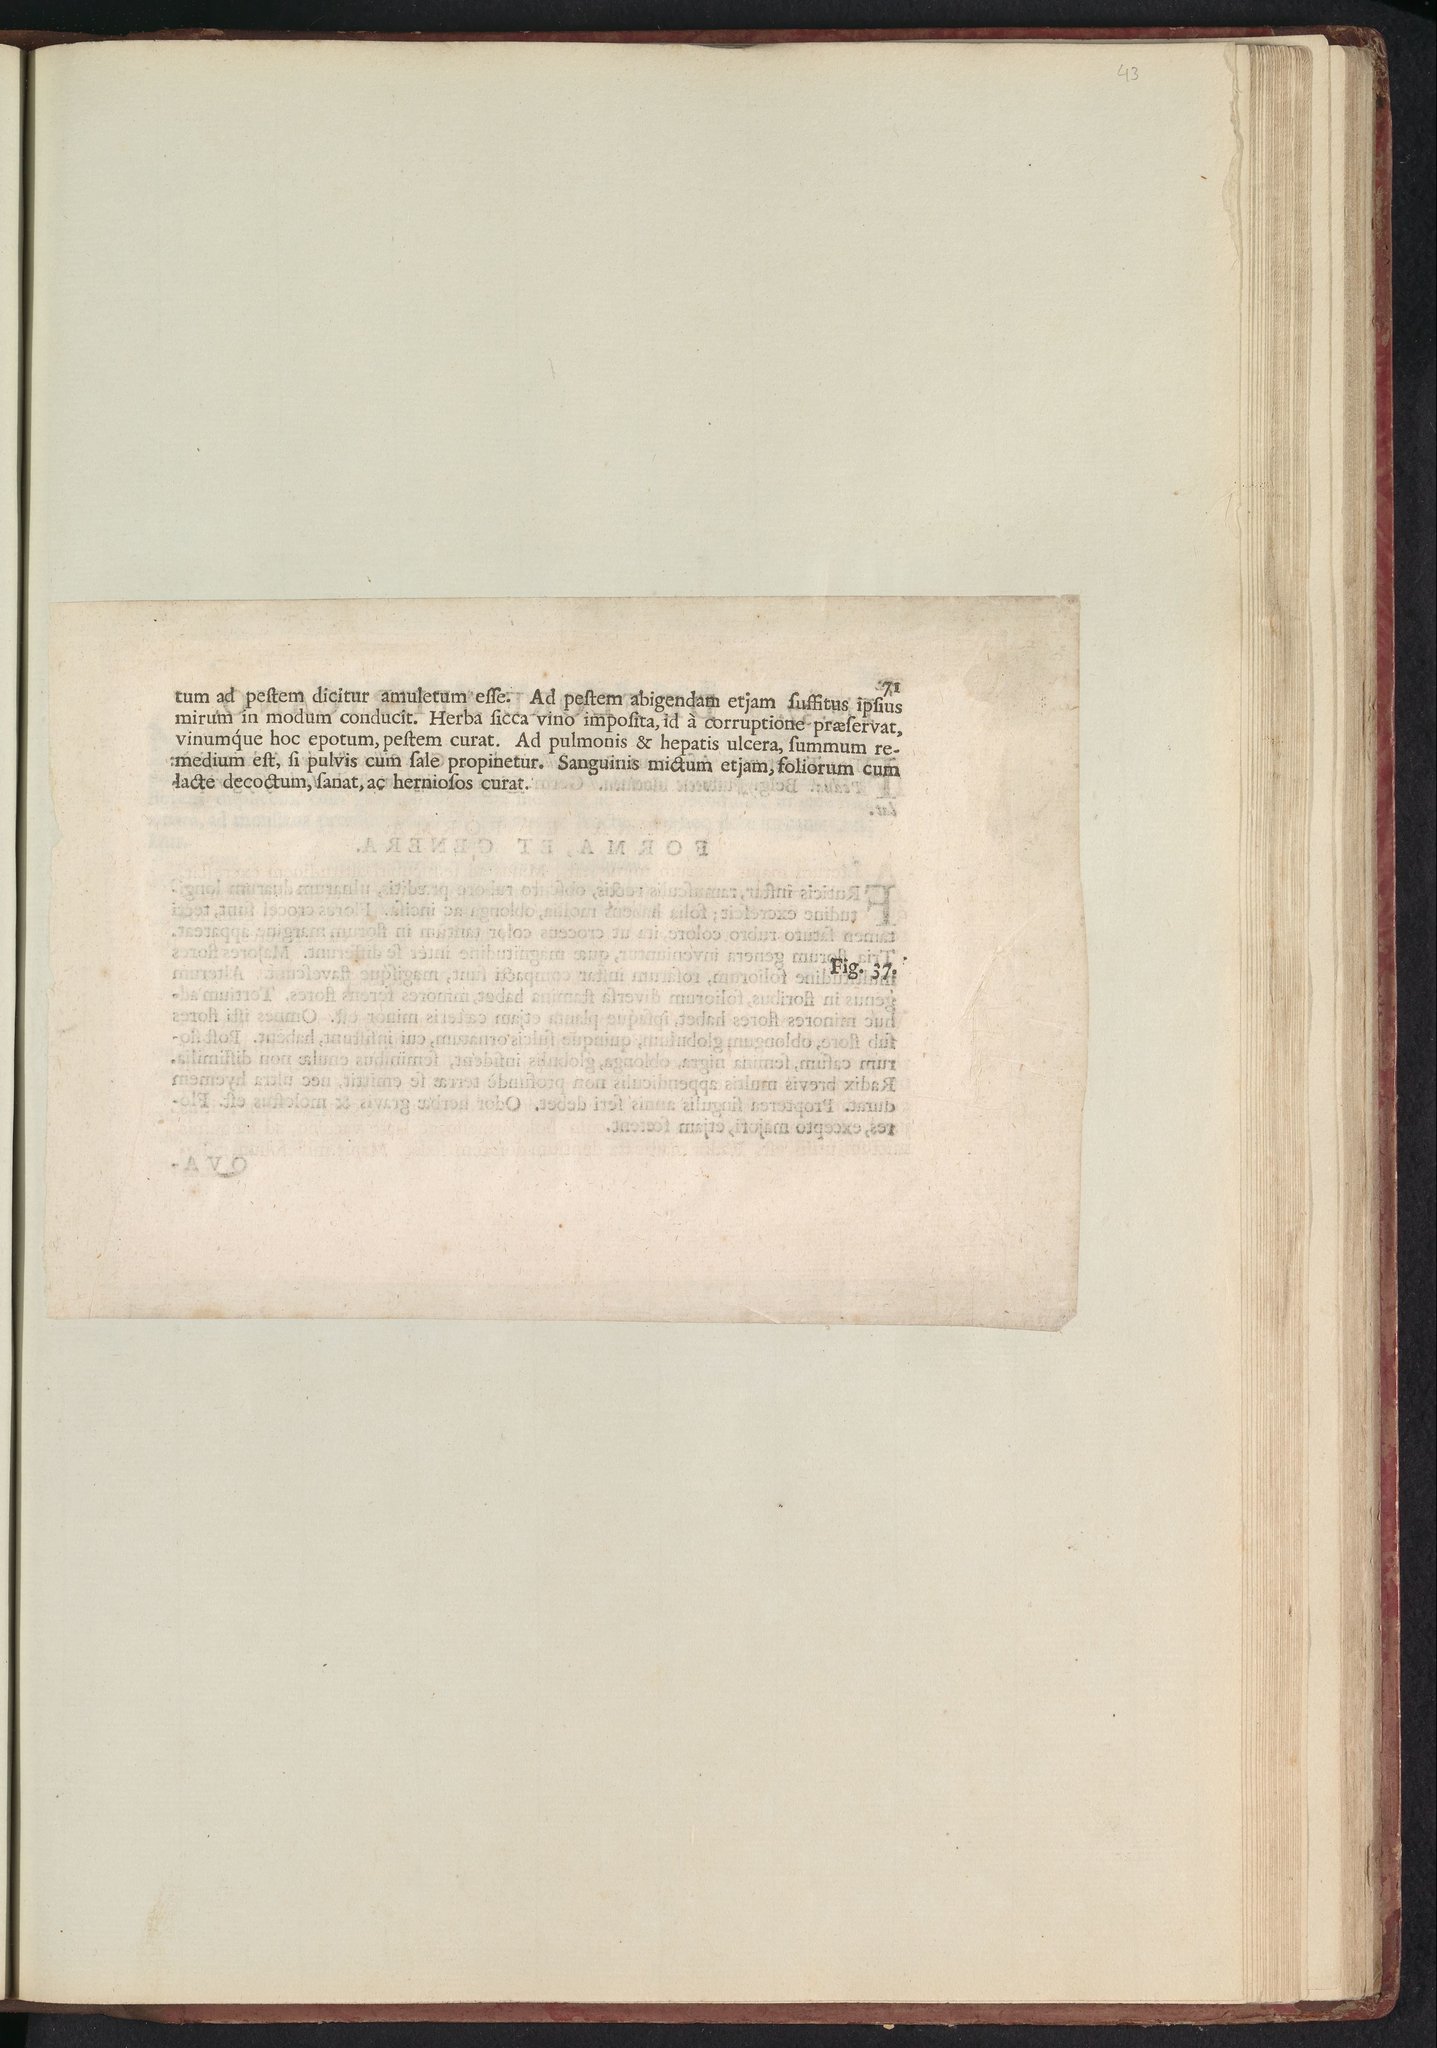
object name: text sheet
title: Fig. 36 'De Millefolio' in De Boodts herbarium van 1640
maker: anselmus boëtius de boodt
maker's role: draughtsman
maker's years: 1550-1632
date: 1640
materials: ink, paper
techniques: letterpress printing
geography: bruges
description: Beschrijving bij Fig. 36 op p. 71 in: Anselmi Boëtii de Boot I.C. Brugensis & Rodolphi II. Imp. Roman. medici a cubiculis Florum, Herbarum, ac fructuum selectiorum icones, & vires pleraeque hactenus ignotæ. Onderdeel van het album met bladen en platen uit De Boodts herbarium van 1640. Het twaalfde van twaalf albums met aquarellen van dieren, vogels en planten bekend rond 1600, gemaakt in opdracht van keizer Rudolf II.